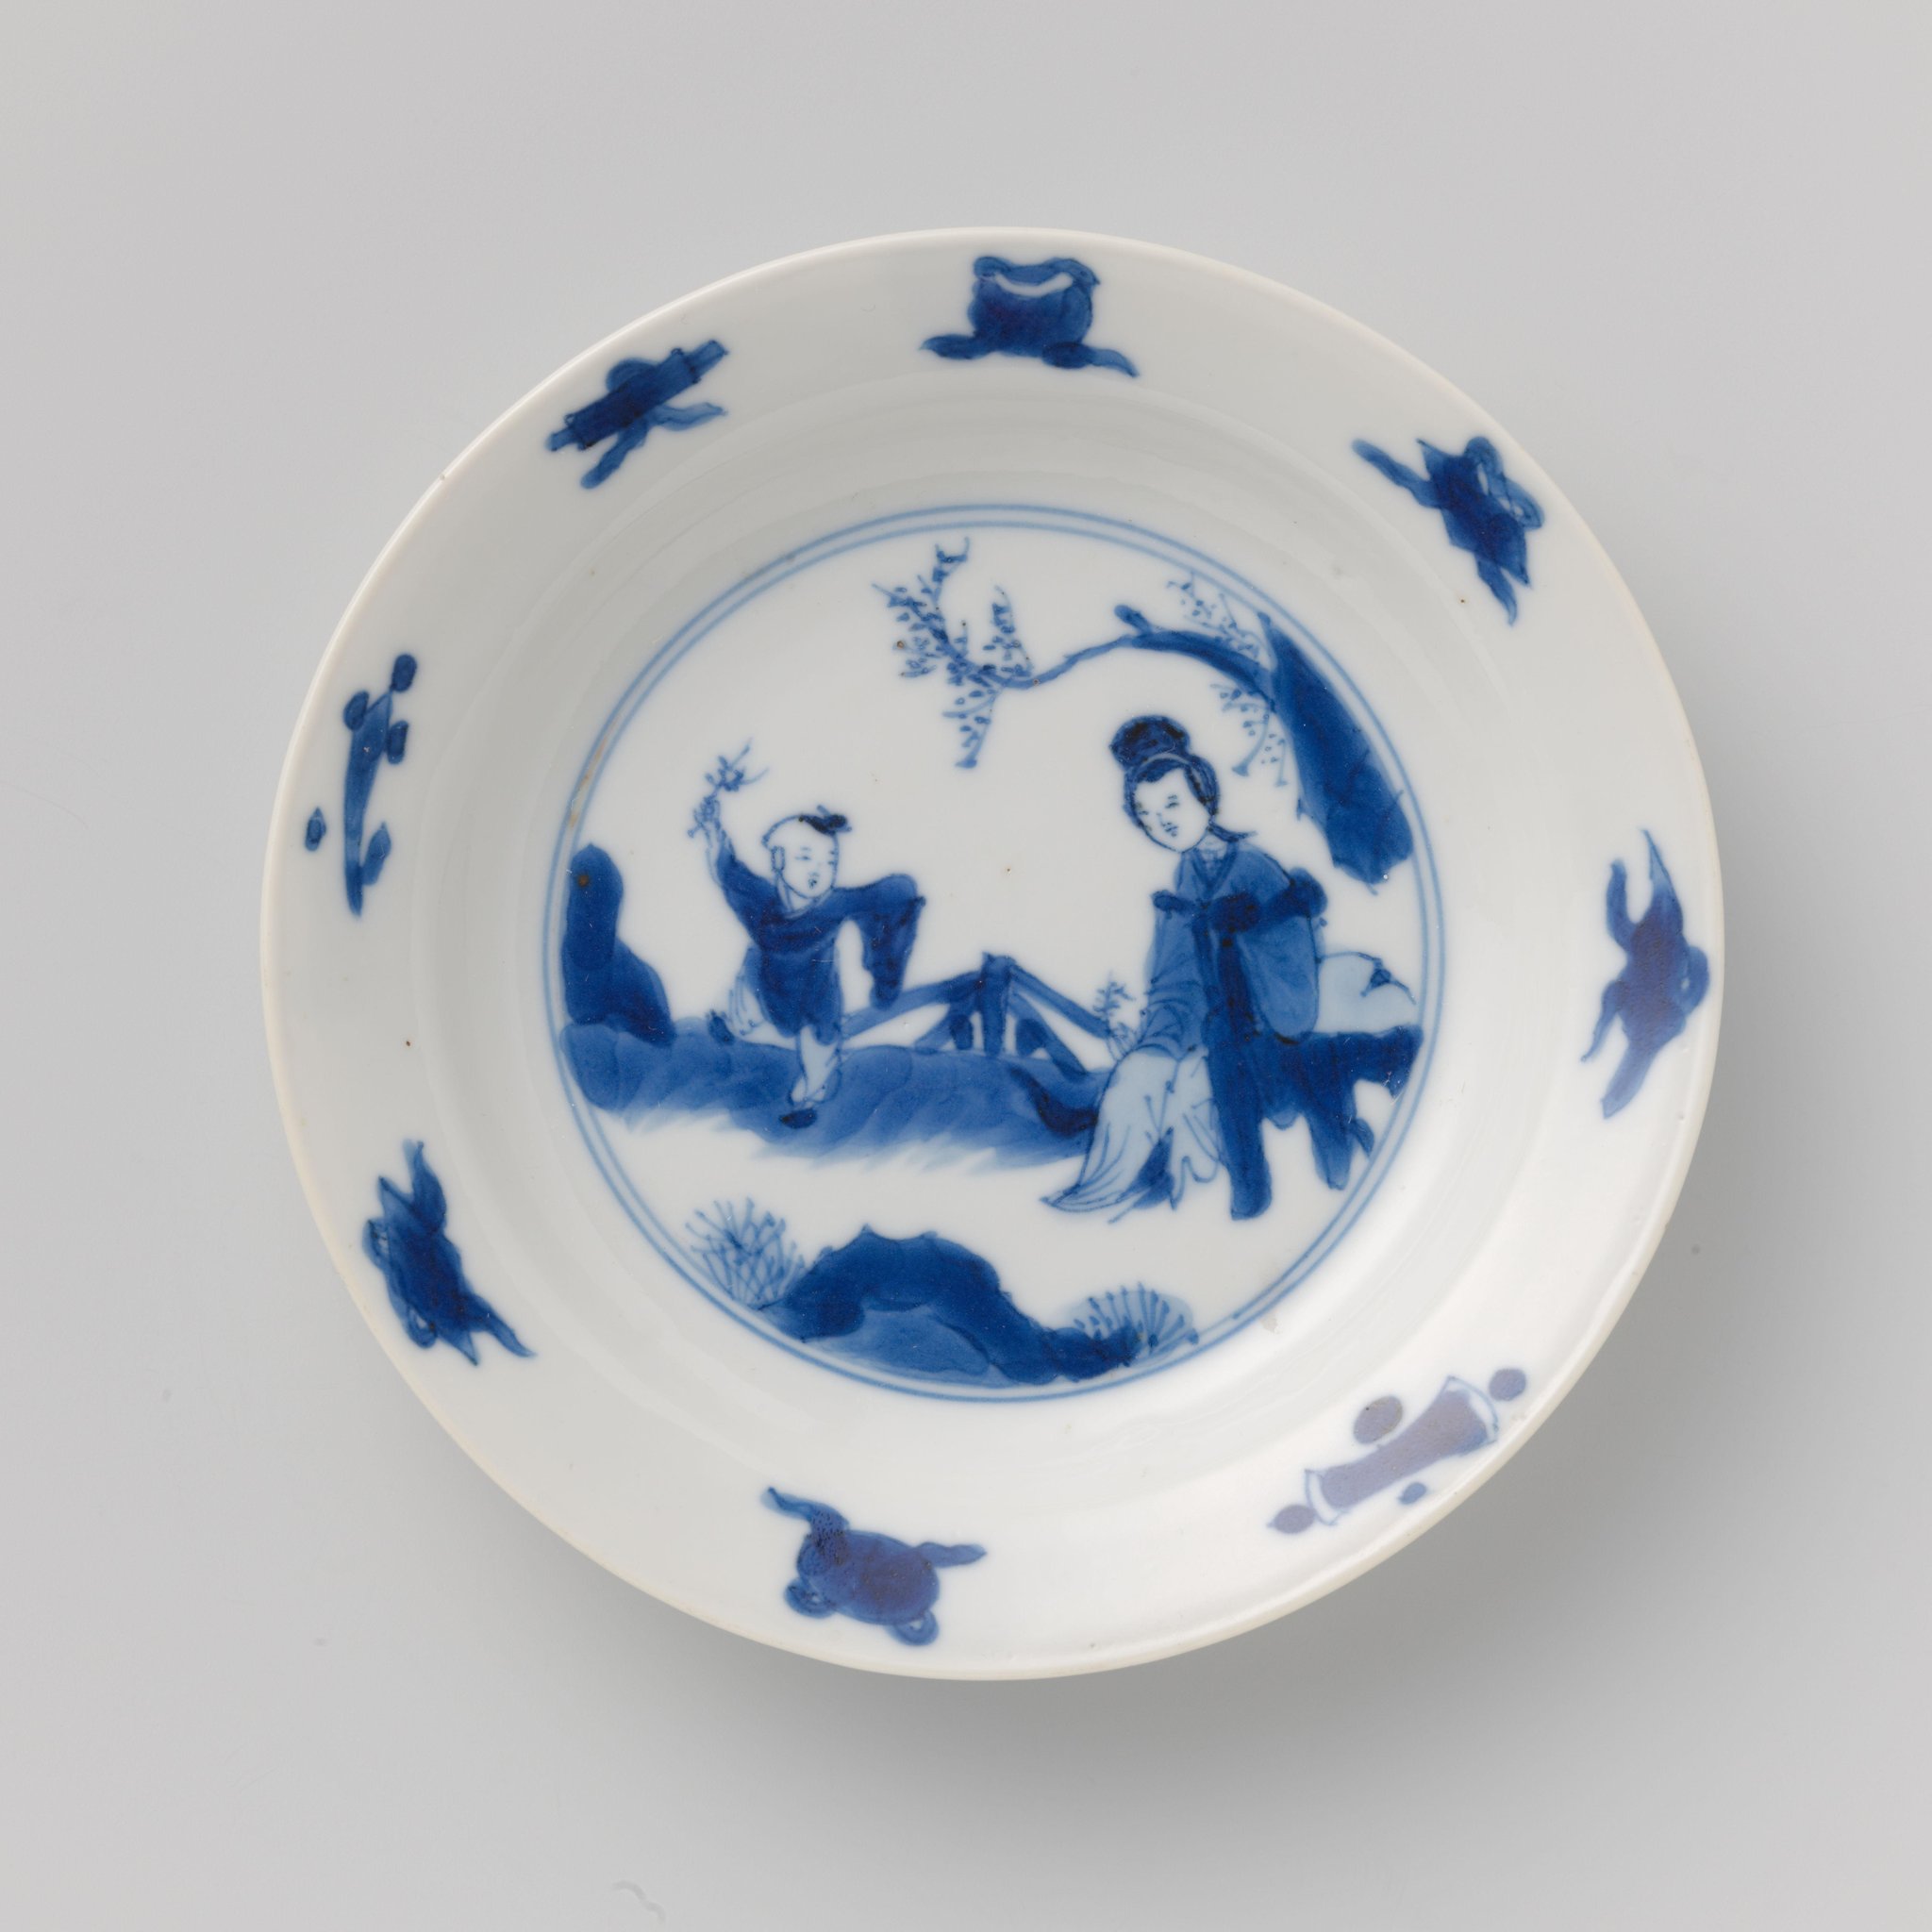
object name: kop en schotel, kop en schotel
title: Saucer with a woman and boy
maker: Anonymous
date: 1680-1720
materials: cobalt, glaze, paint, porcelain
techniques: firing, turning, vitrification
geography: china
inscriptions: mark: ‘成 化 年 製’, mark: ‘大 明 宣 德 年 製’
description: Schotel, twee Chinezen in een landschap. Klokvormige kop met lijs.